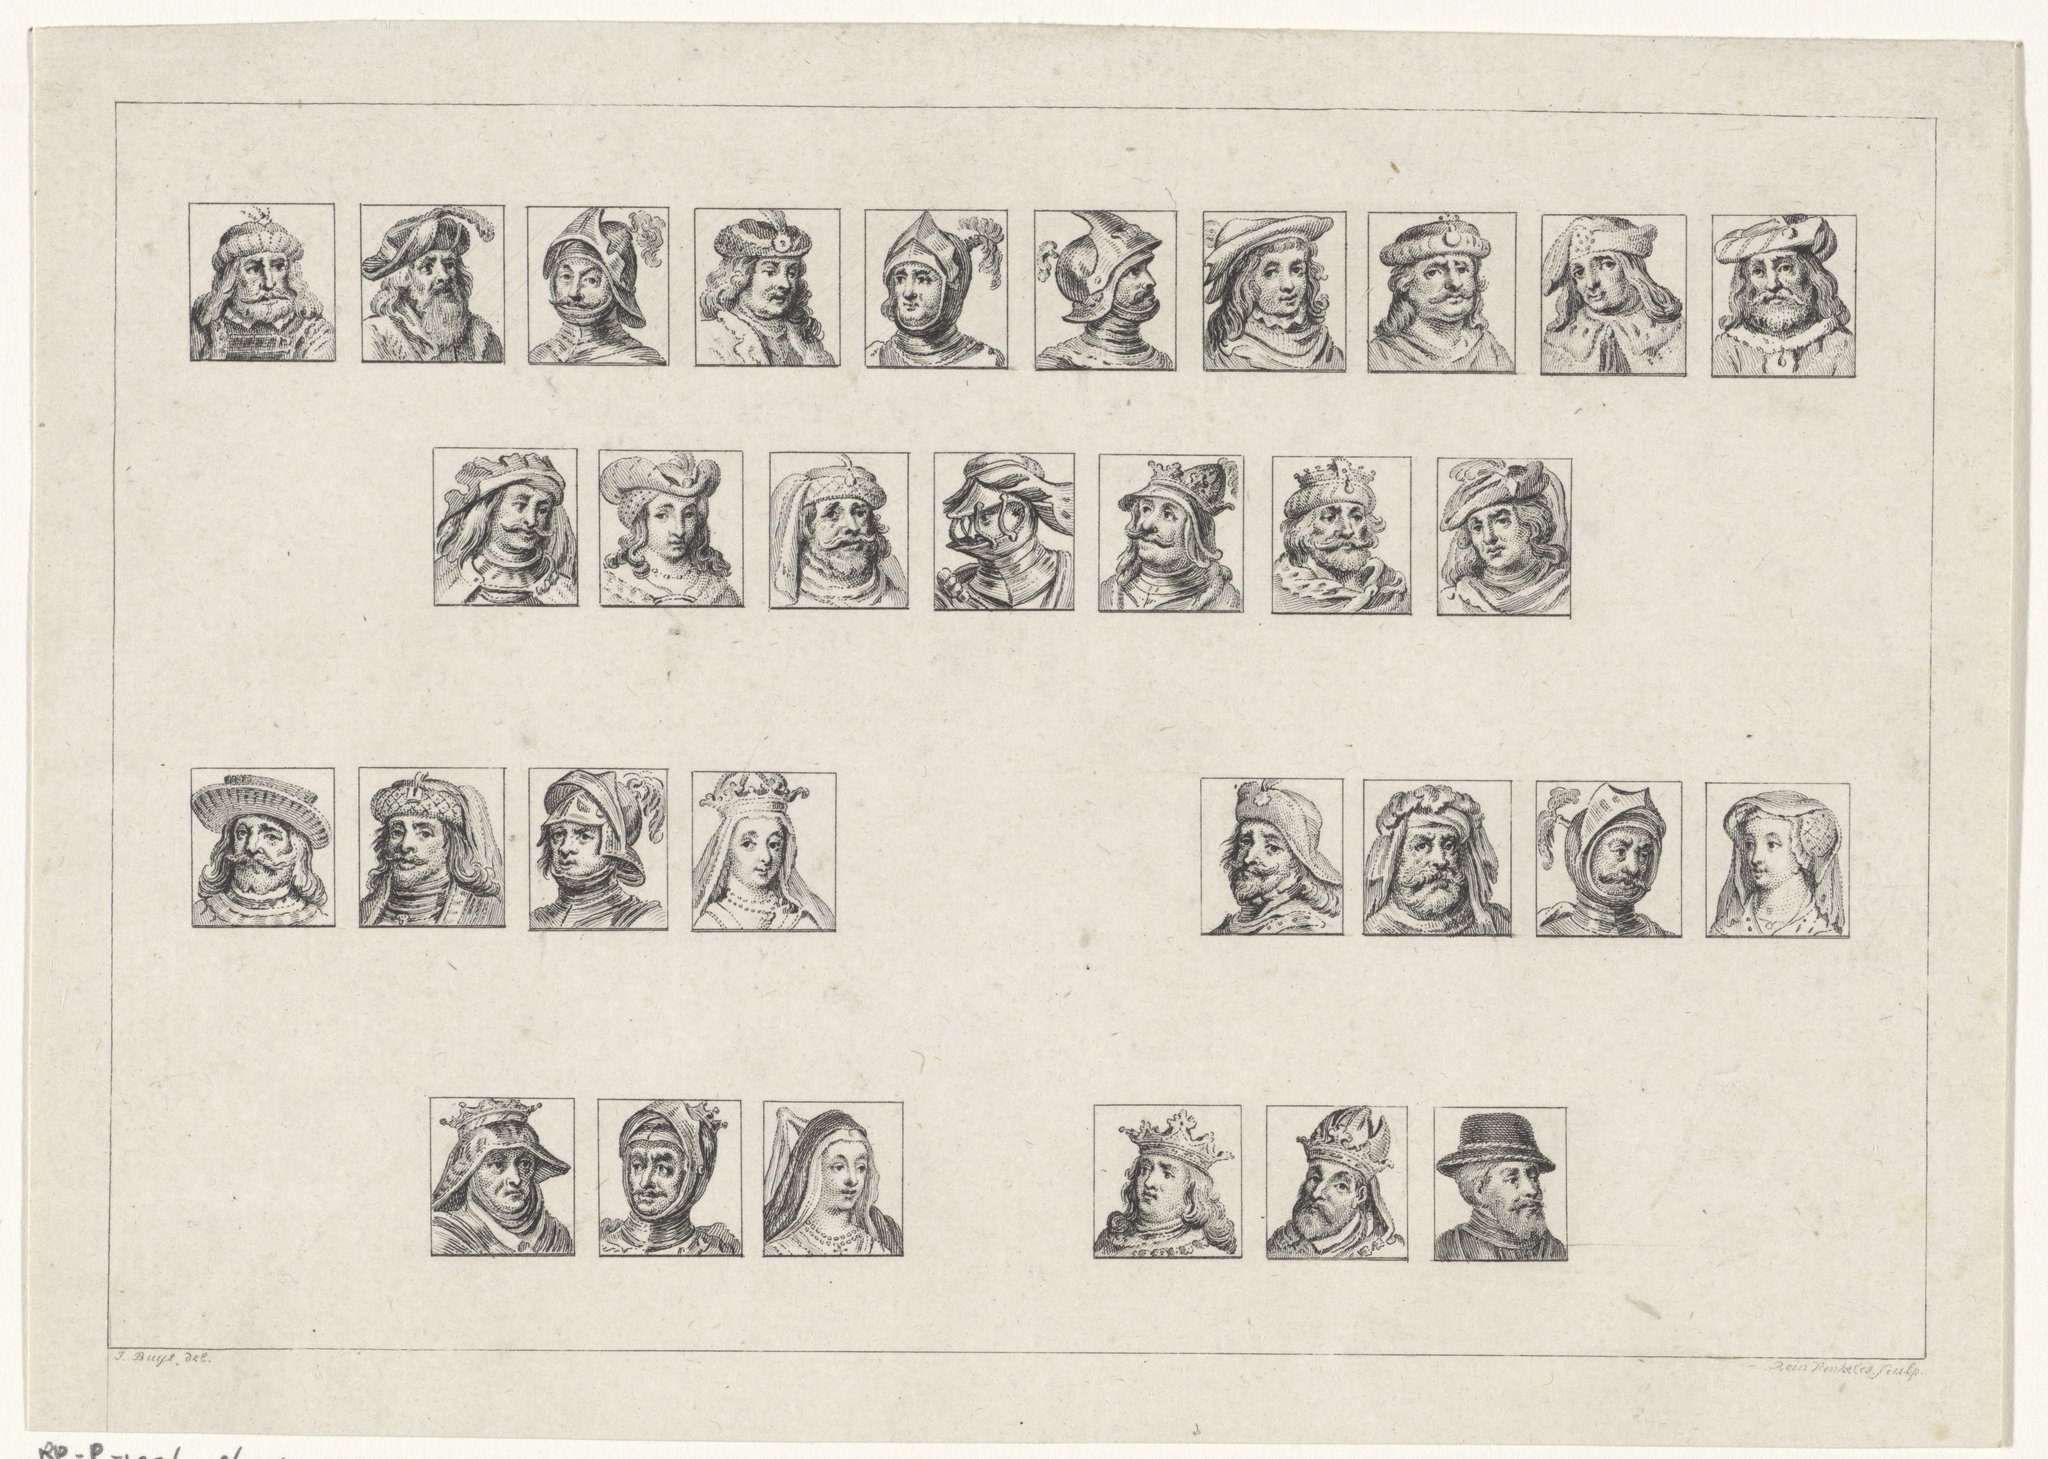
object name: print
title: Graven en gravinnen van Holland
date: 1751-1816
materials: paper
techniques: etching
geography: amsterdam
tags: nobility and patriciate; chivalry, knighthood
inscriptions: collector's mark: Lugt 2228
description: Eenendertig graven en gravinnen van Holland.